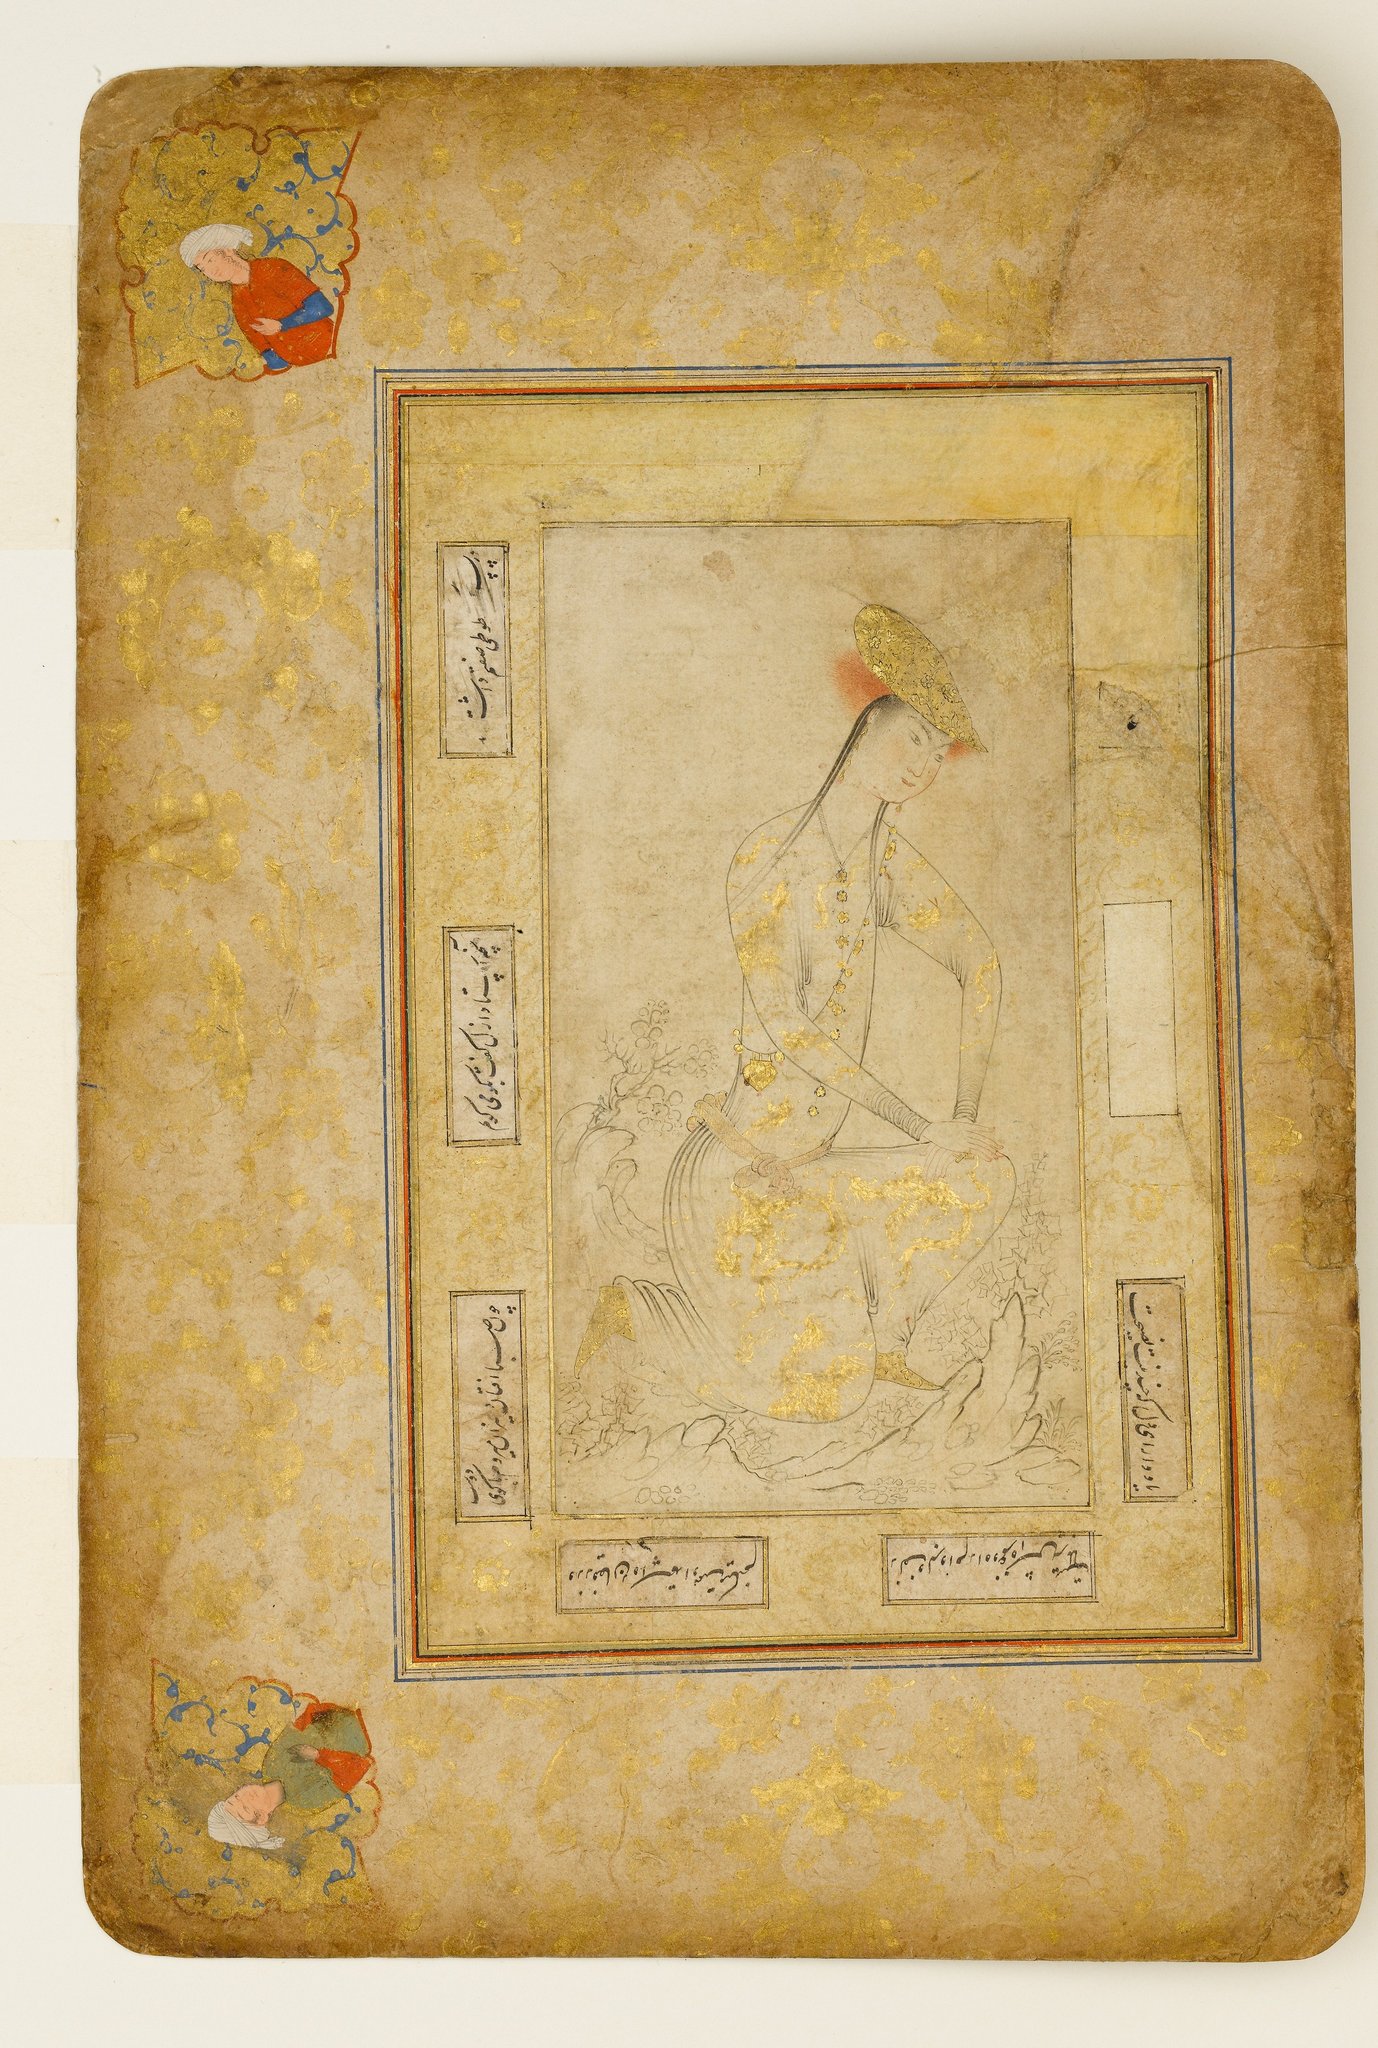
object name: illustrated single work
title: Kneeling Youth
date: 1567-1600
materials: gold, ink, paper, watercolor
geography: iran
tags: men,portraits